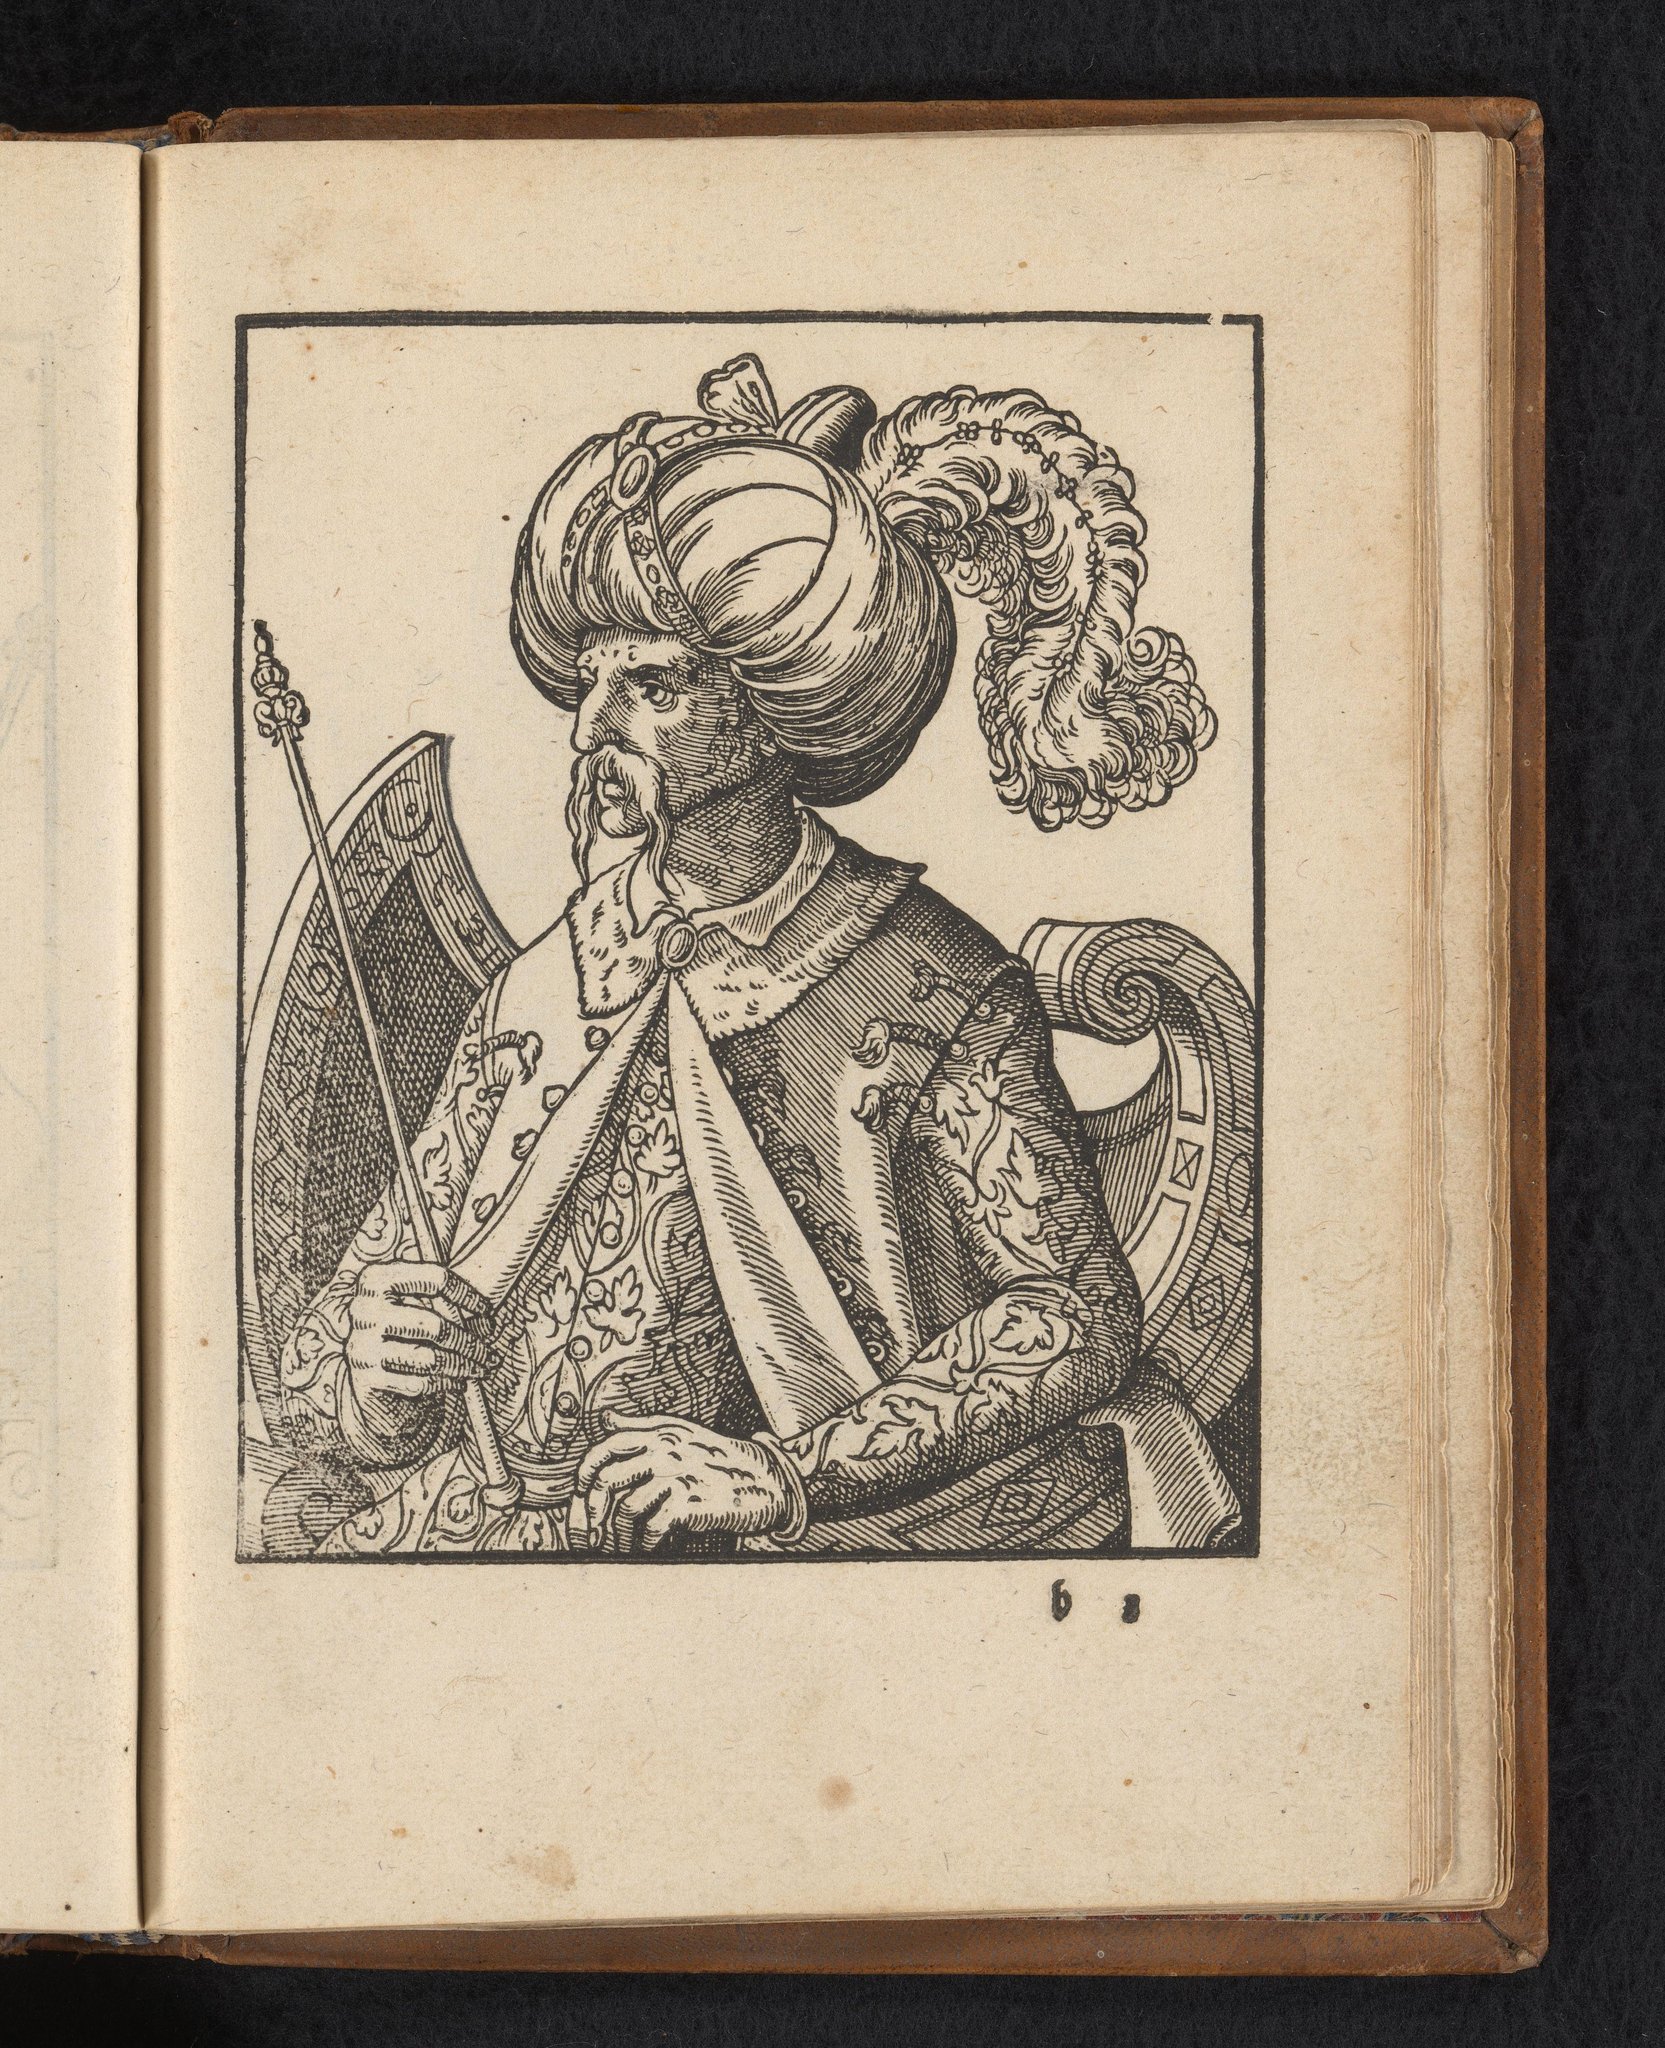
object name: print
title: Ottomaanse veldheer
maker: Anonymous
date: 1578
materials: paper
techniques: woodcut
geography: nuremberg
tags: asiatic races and peoples: turks, head-gear: turban, the soldier; the soldier's life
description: Een Ottomaanse veldheer, zittend naar links, in de hand een scepter, op het hoofd een tulband met een pluim. Onderdeel van het modelboek Enchiridion artis pingendi, fingendi & sculpendi met 108 figuren bedoeld voor beginnende schilders, beeldhouwers en prentmakers.